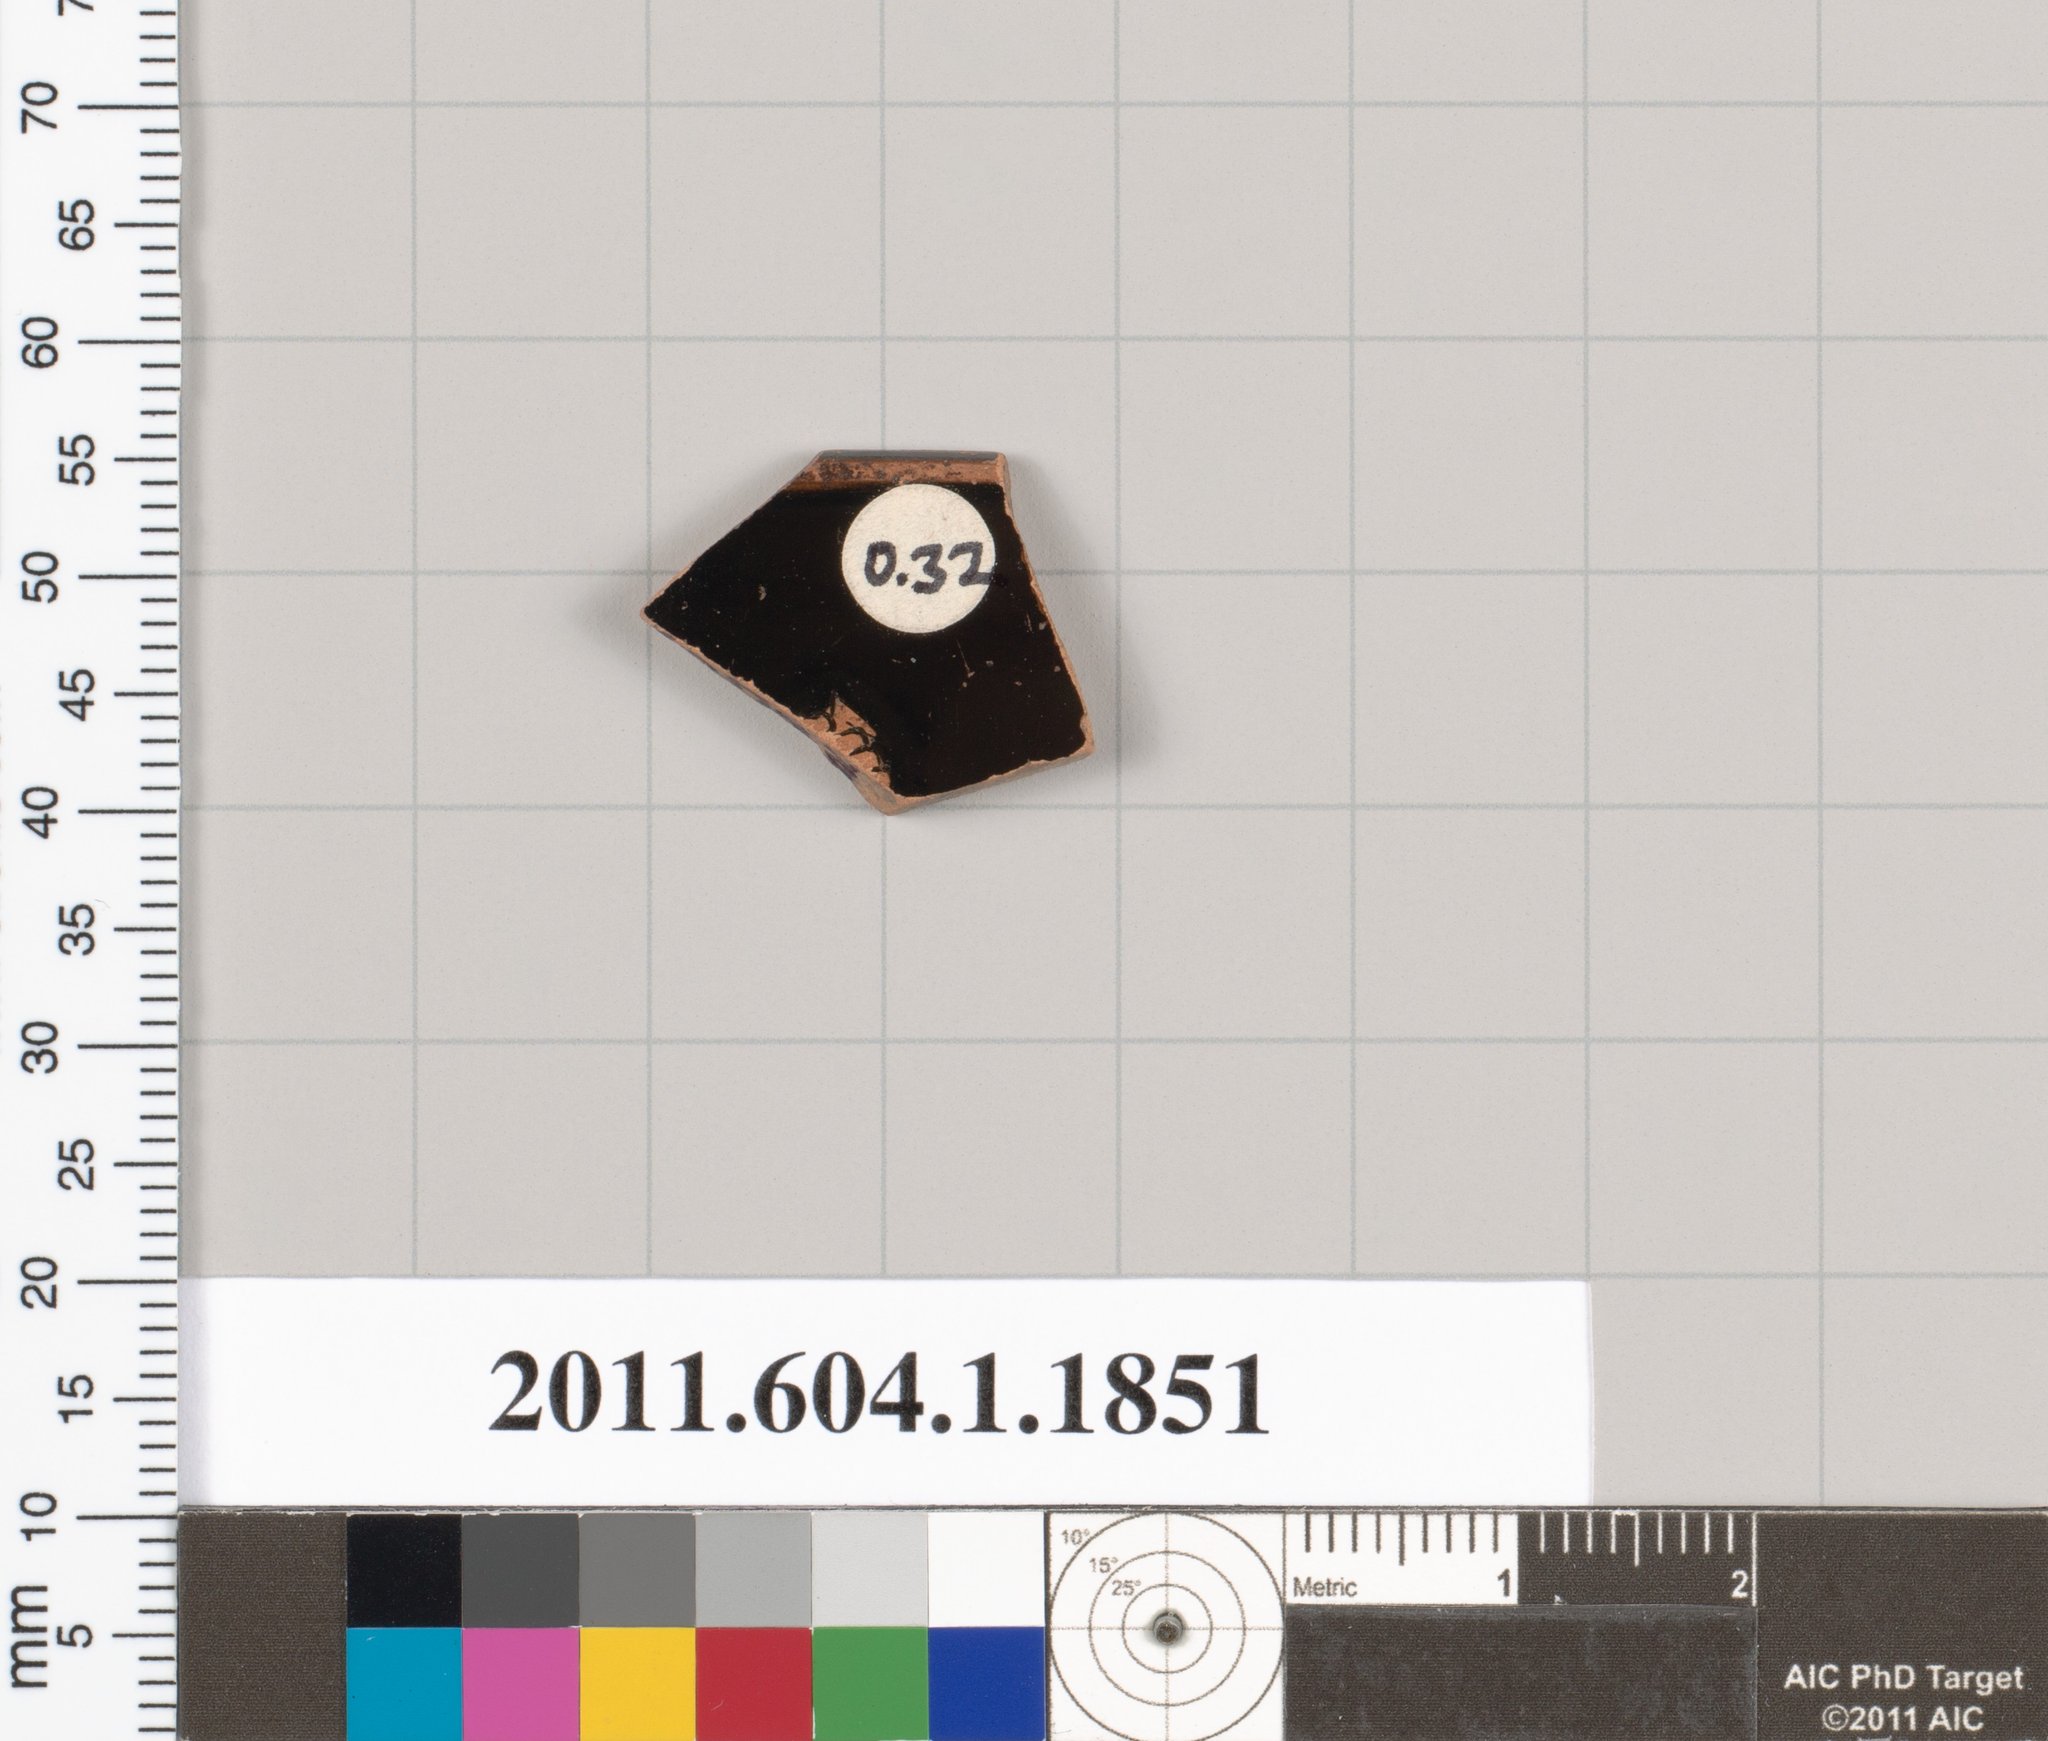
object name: kylix fragment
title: Terracotta rim fragment of a kylix (drinking cup)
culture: greek, attic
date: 500-401 BCE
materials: terracotta